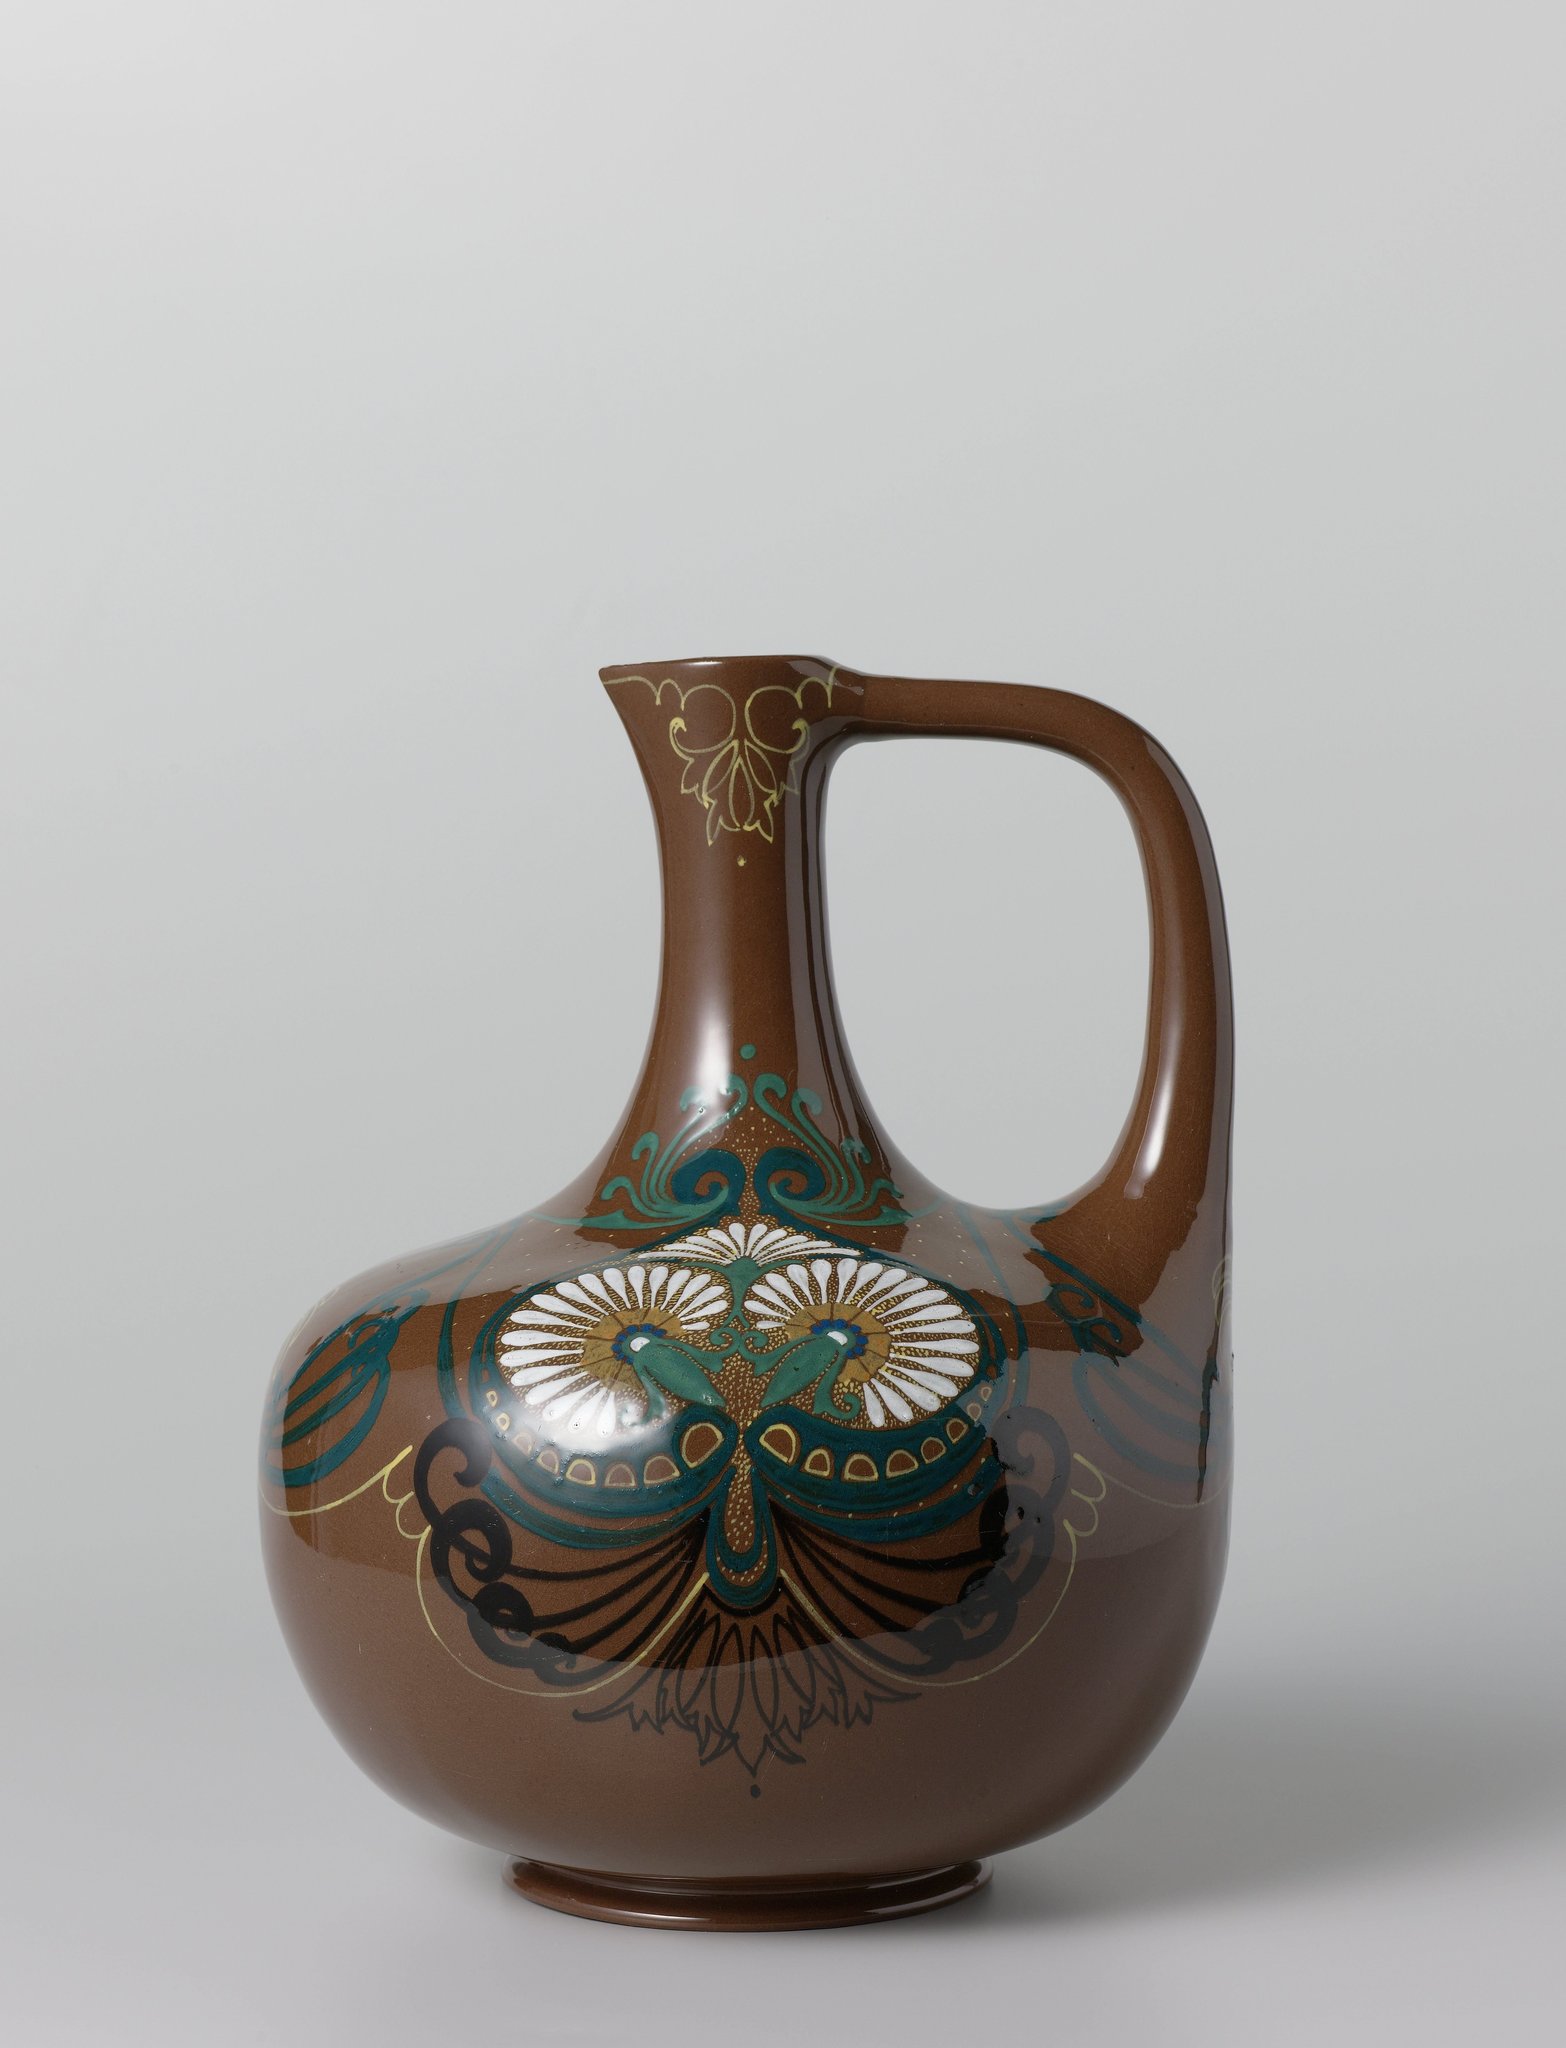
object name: ewer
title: Kan met polychroom gestileerd bloempatroon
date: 1910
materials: earthenware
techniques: painted, vitrification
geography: arnhem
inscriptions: mark: ‘haan in veelhoek; getal 67.’, monogram: ‘JZ’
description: Kan van bruin aardewerk, afgeplat bolvormig lichaam met cilindervormige lange hals met tuit en oor tussen mondrand en schouder. Beschilderd in groen, geel, turkoois, blauw, zwart en wit, met een gestileerd bloempatroon.